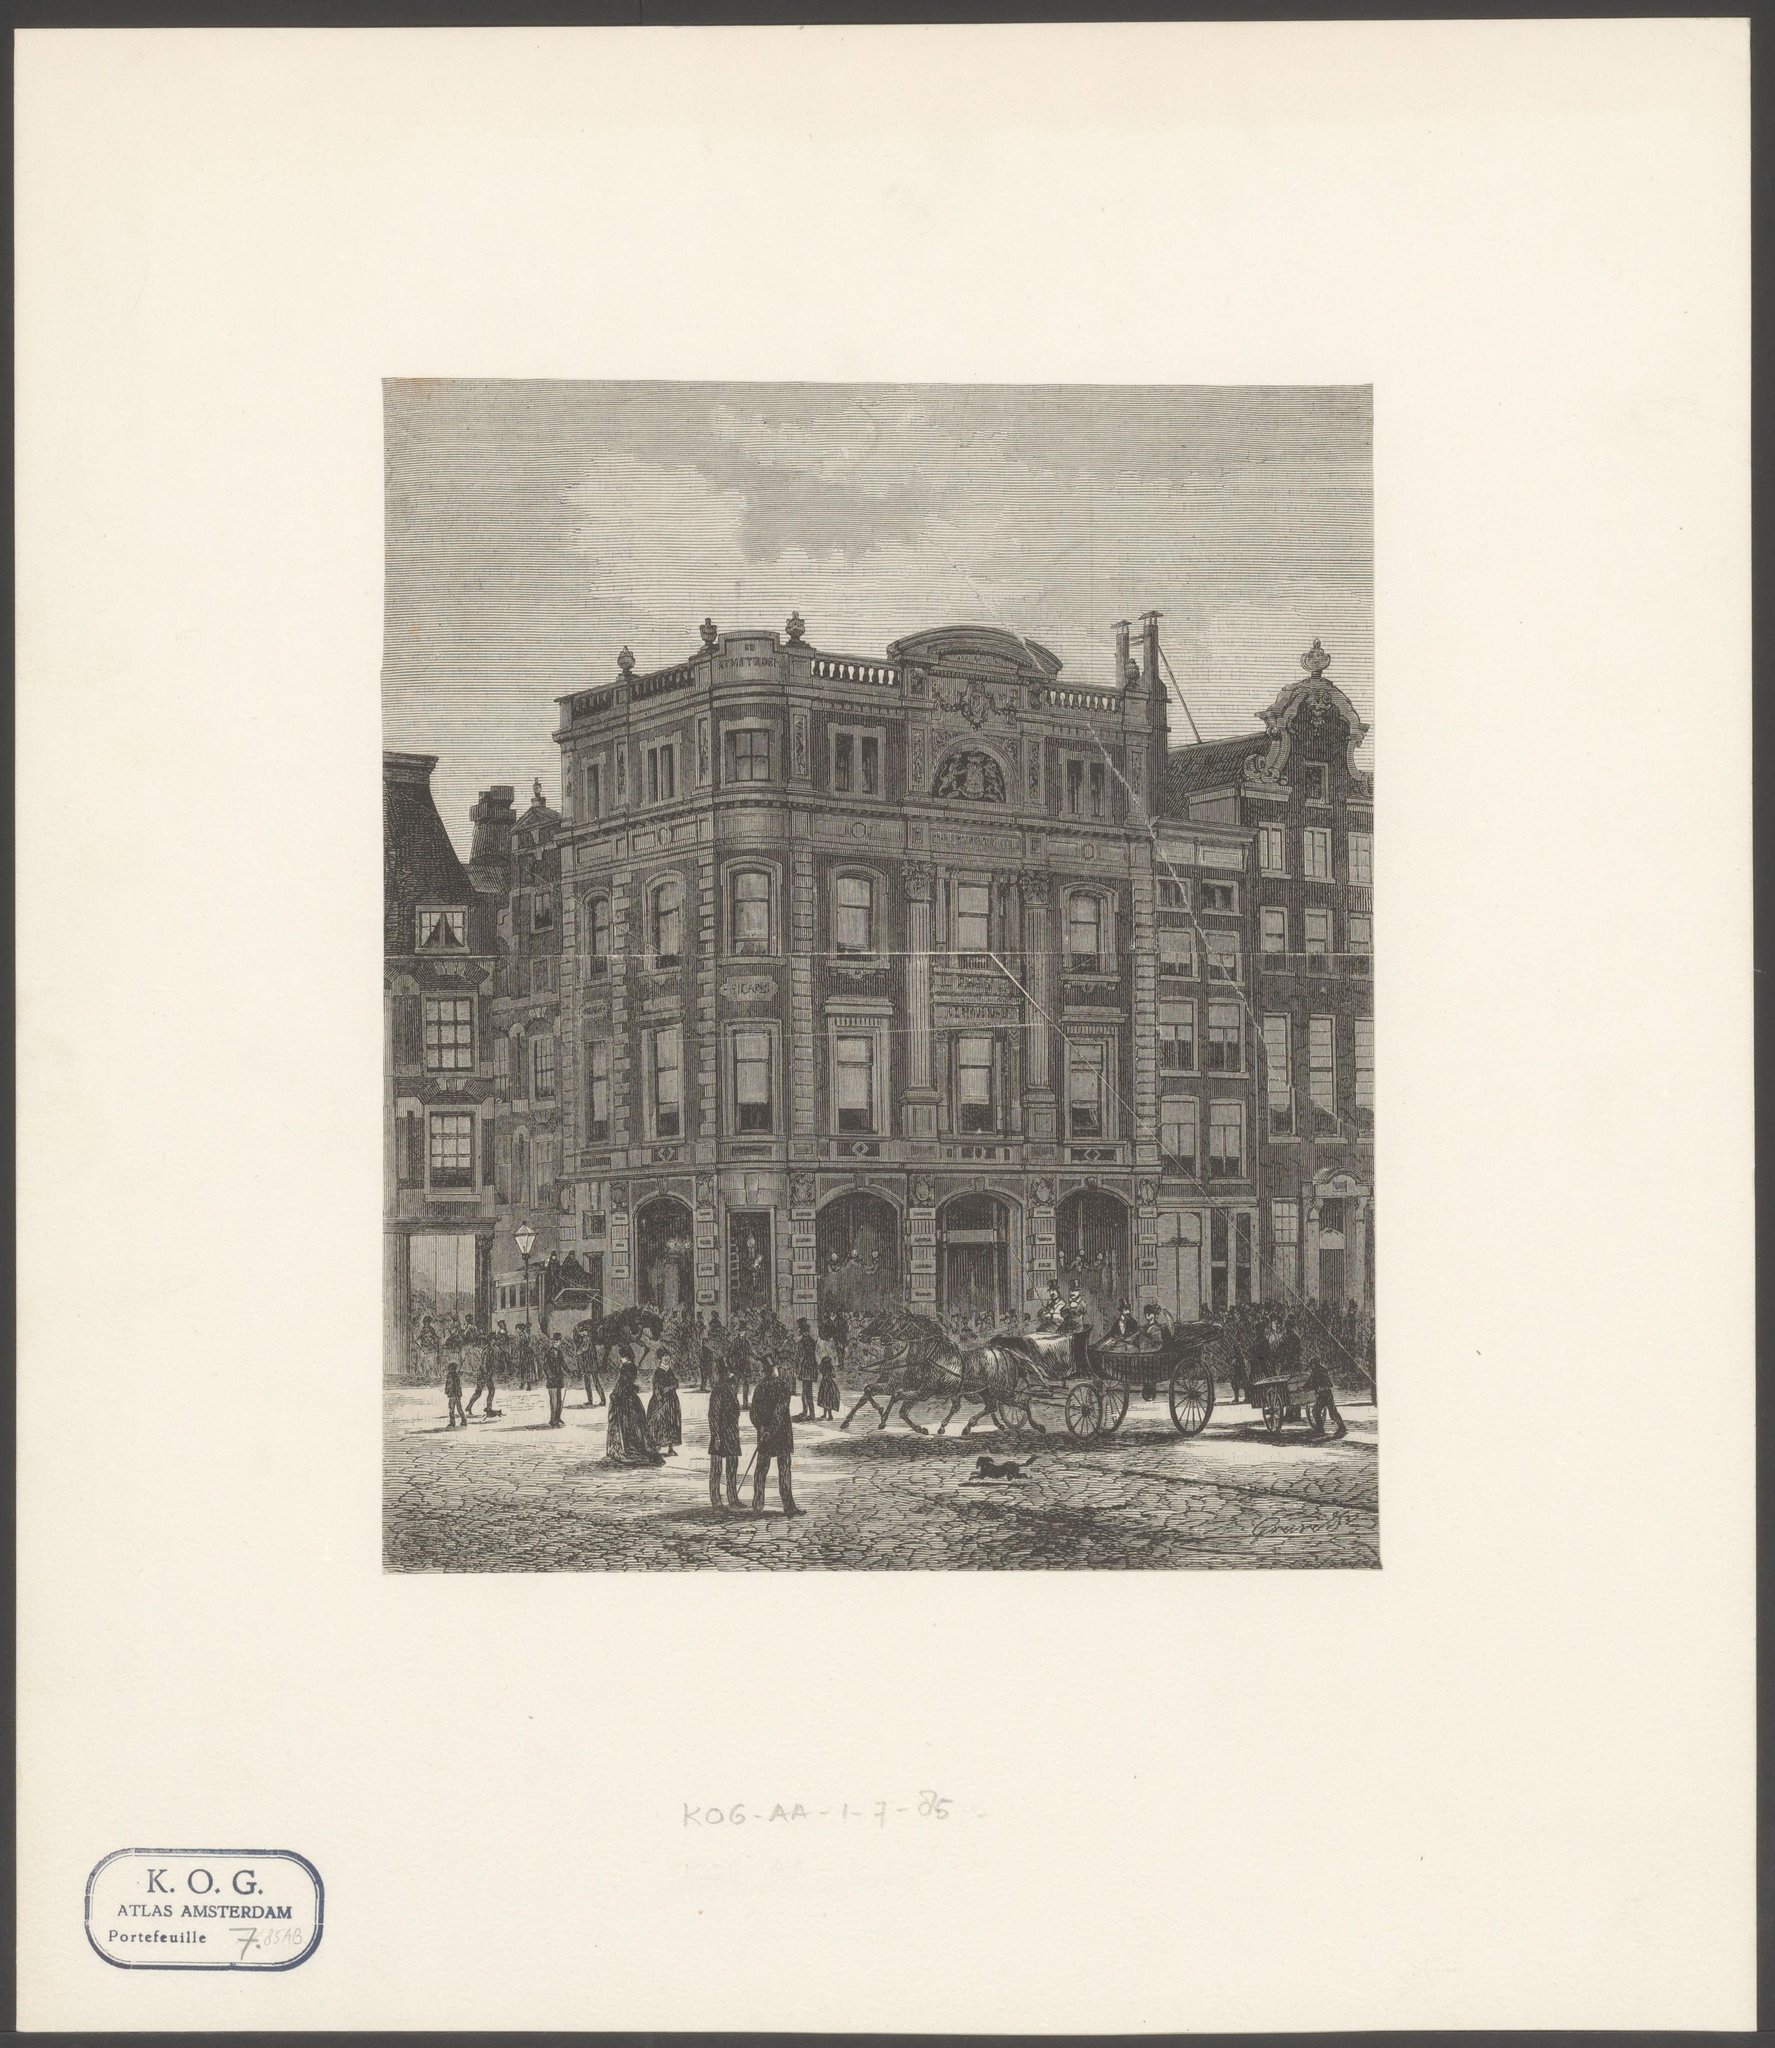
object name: print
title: Gezicht op het huis van de firma P.G.C. Hajenius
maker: Anonymous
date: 1914-1950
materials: paper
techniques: engraving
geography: amsterdam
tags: square, place, circus, etc., city-view in general; 'veduta', façade (of house or building)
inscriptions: signature: ‘Gre[...]Jr’, collector's mark: ‘7’ Lugt 1641b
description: Onderwerpsrubriek binnen de Atlas Amsterdam: Dam (na 1835).